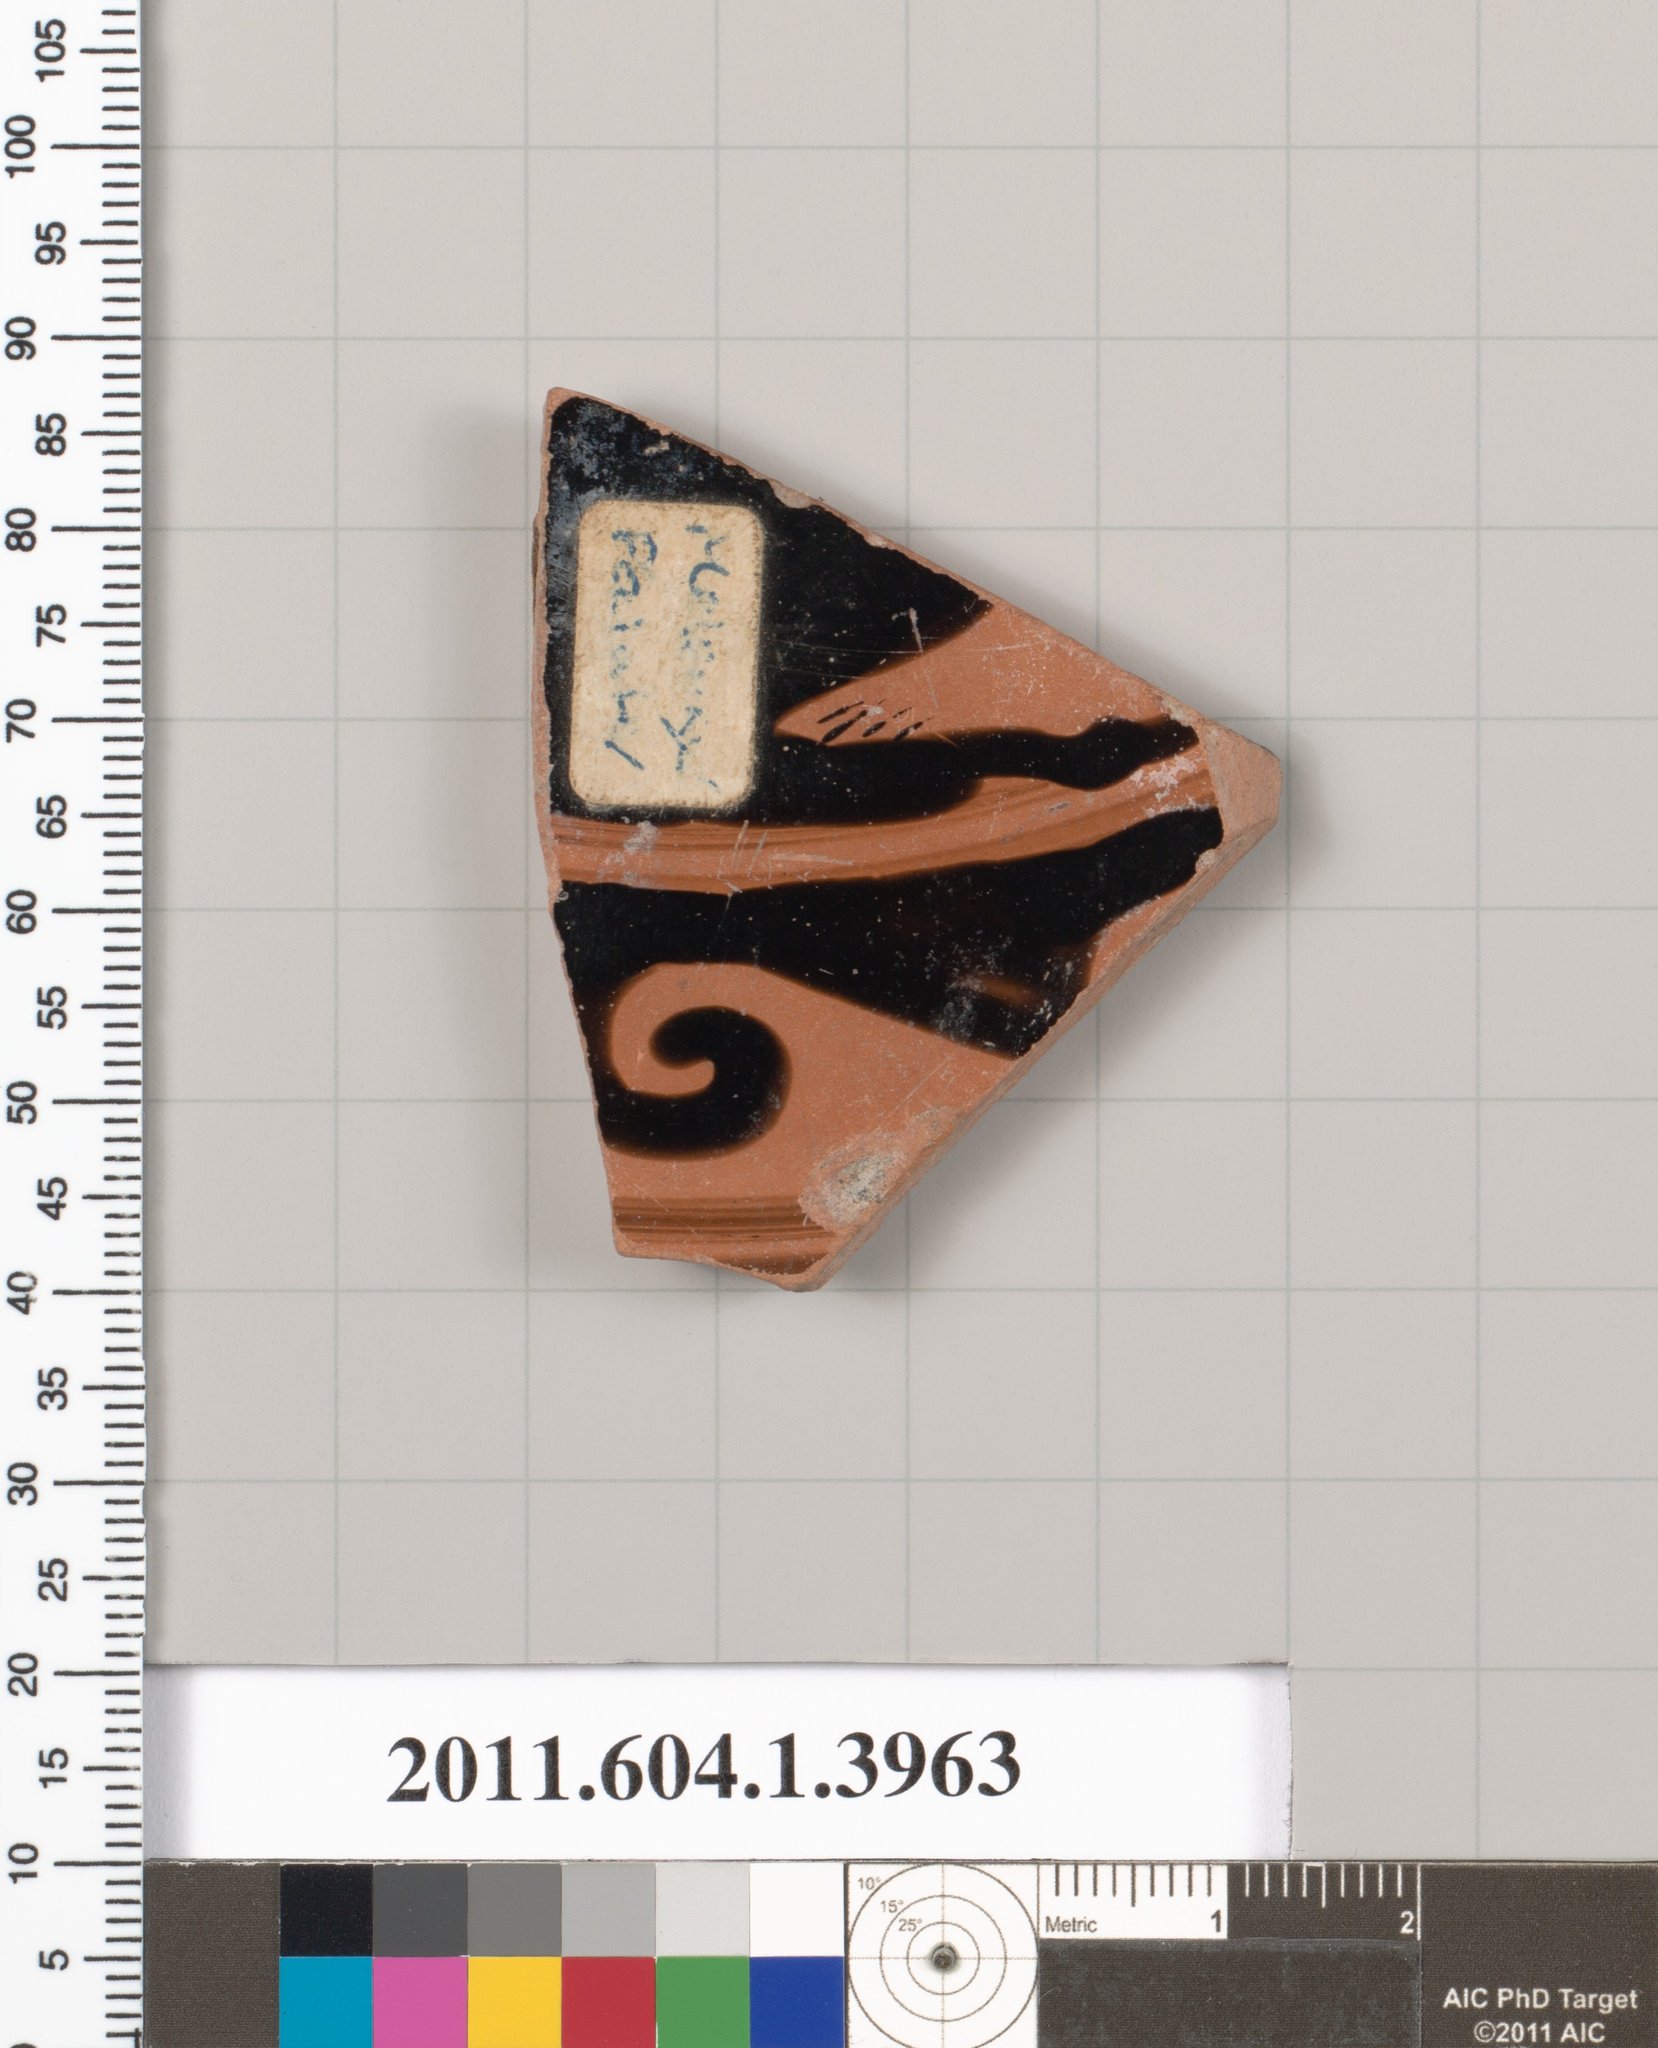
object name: kylix fragment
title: Terracotta fragment of a kylix (drinking cup)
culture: greek, attic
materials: terracotta